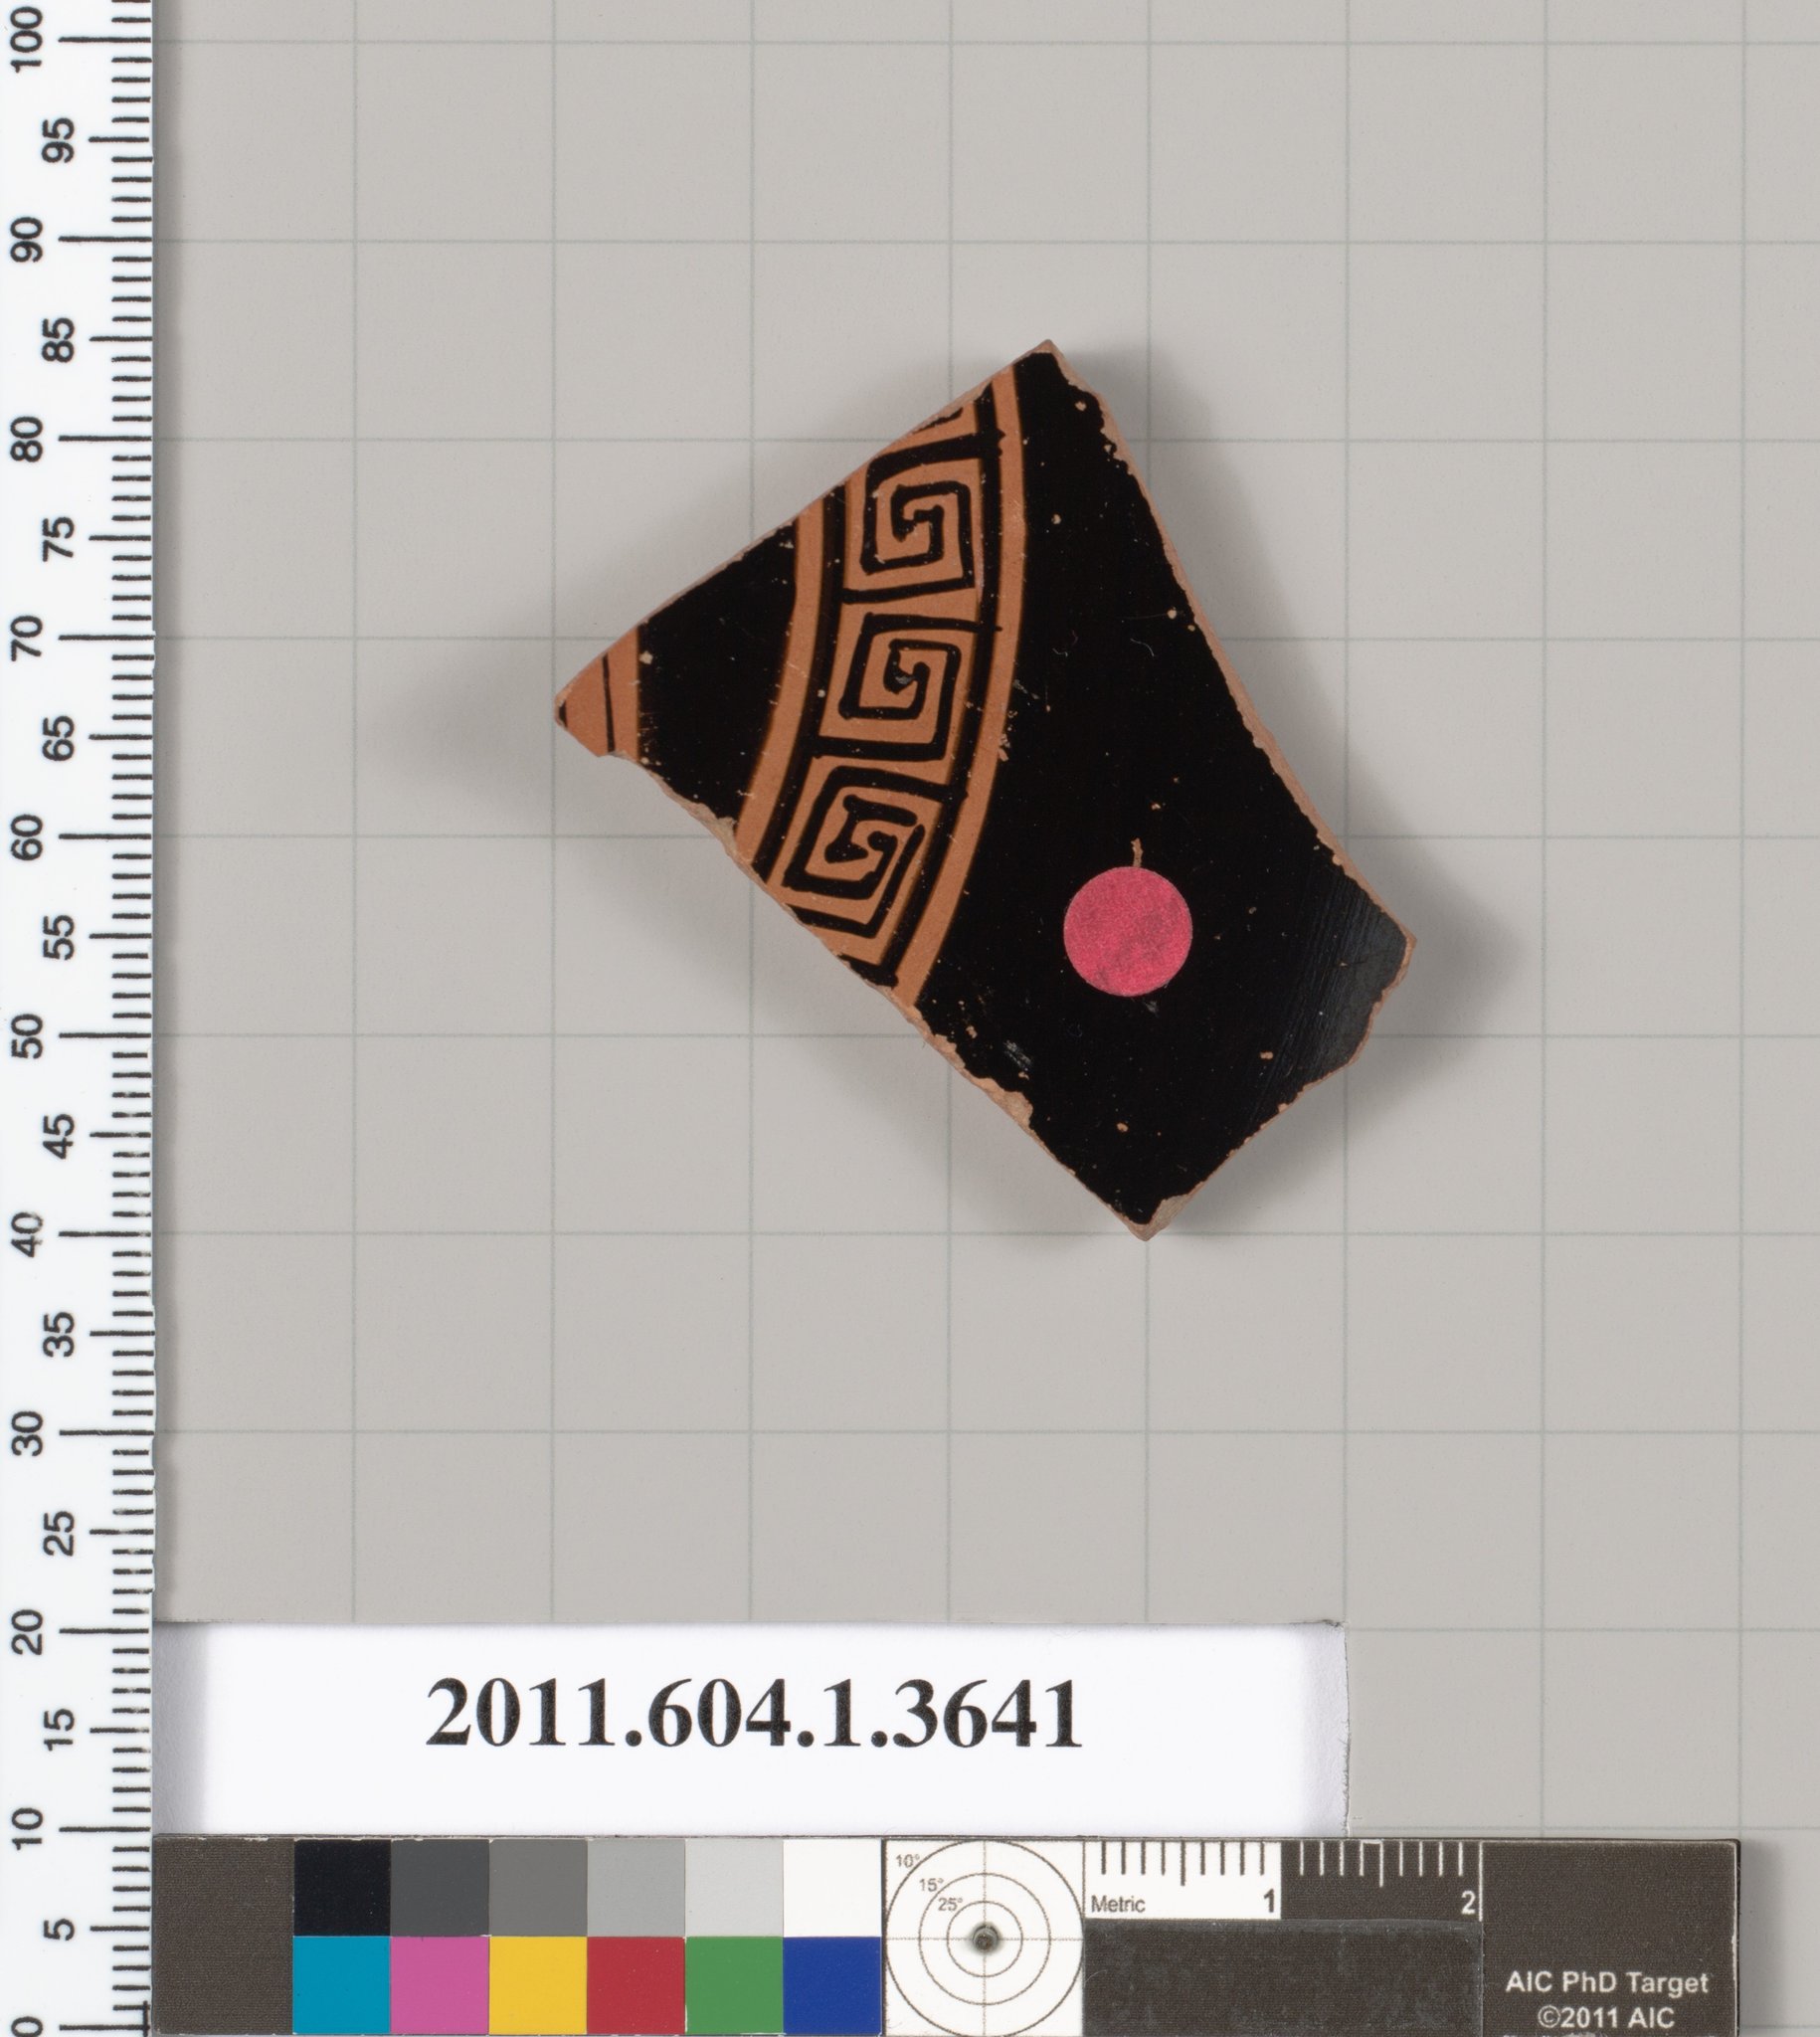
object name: kylix fragment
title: Terracotta fragment of a kylix (drinking cup)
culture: greek, attic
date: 475-451 BCE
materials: terracotta